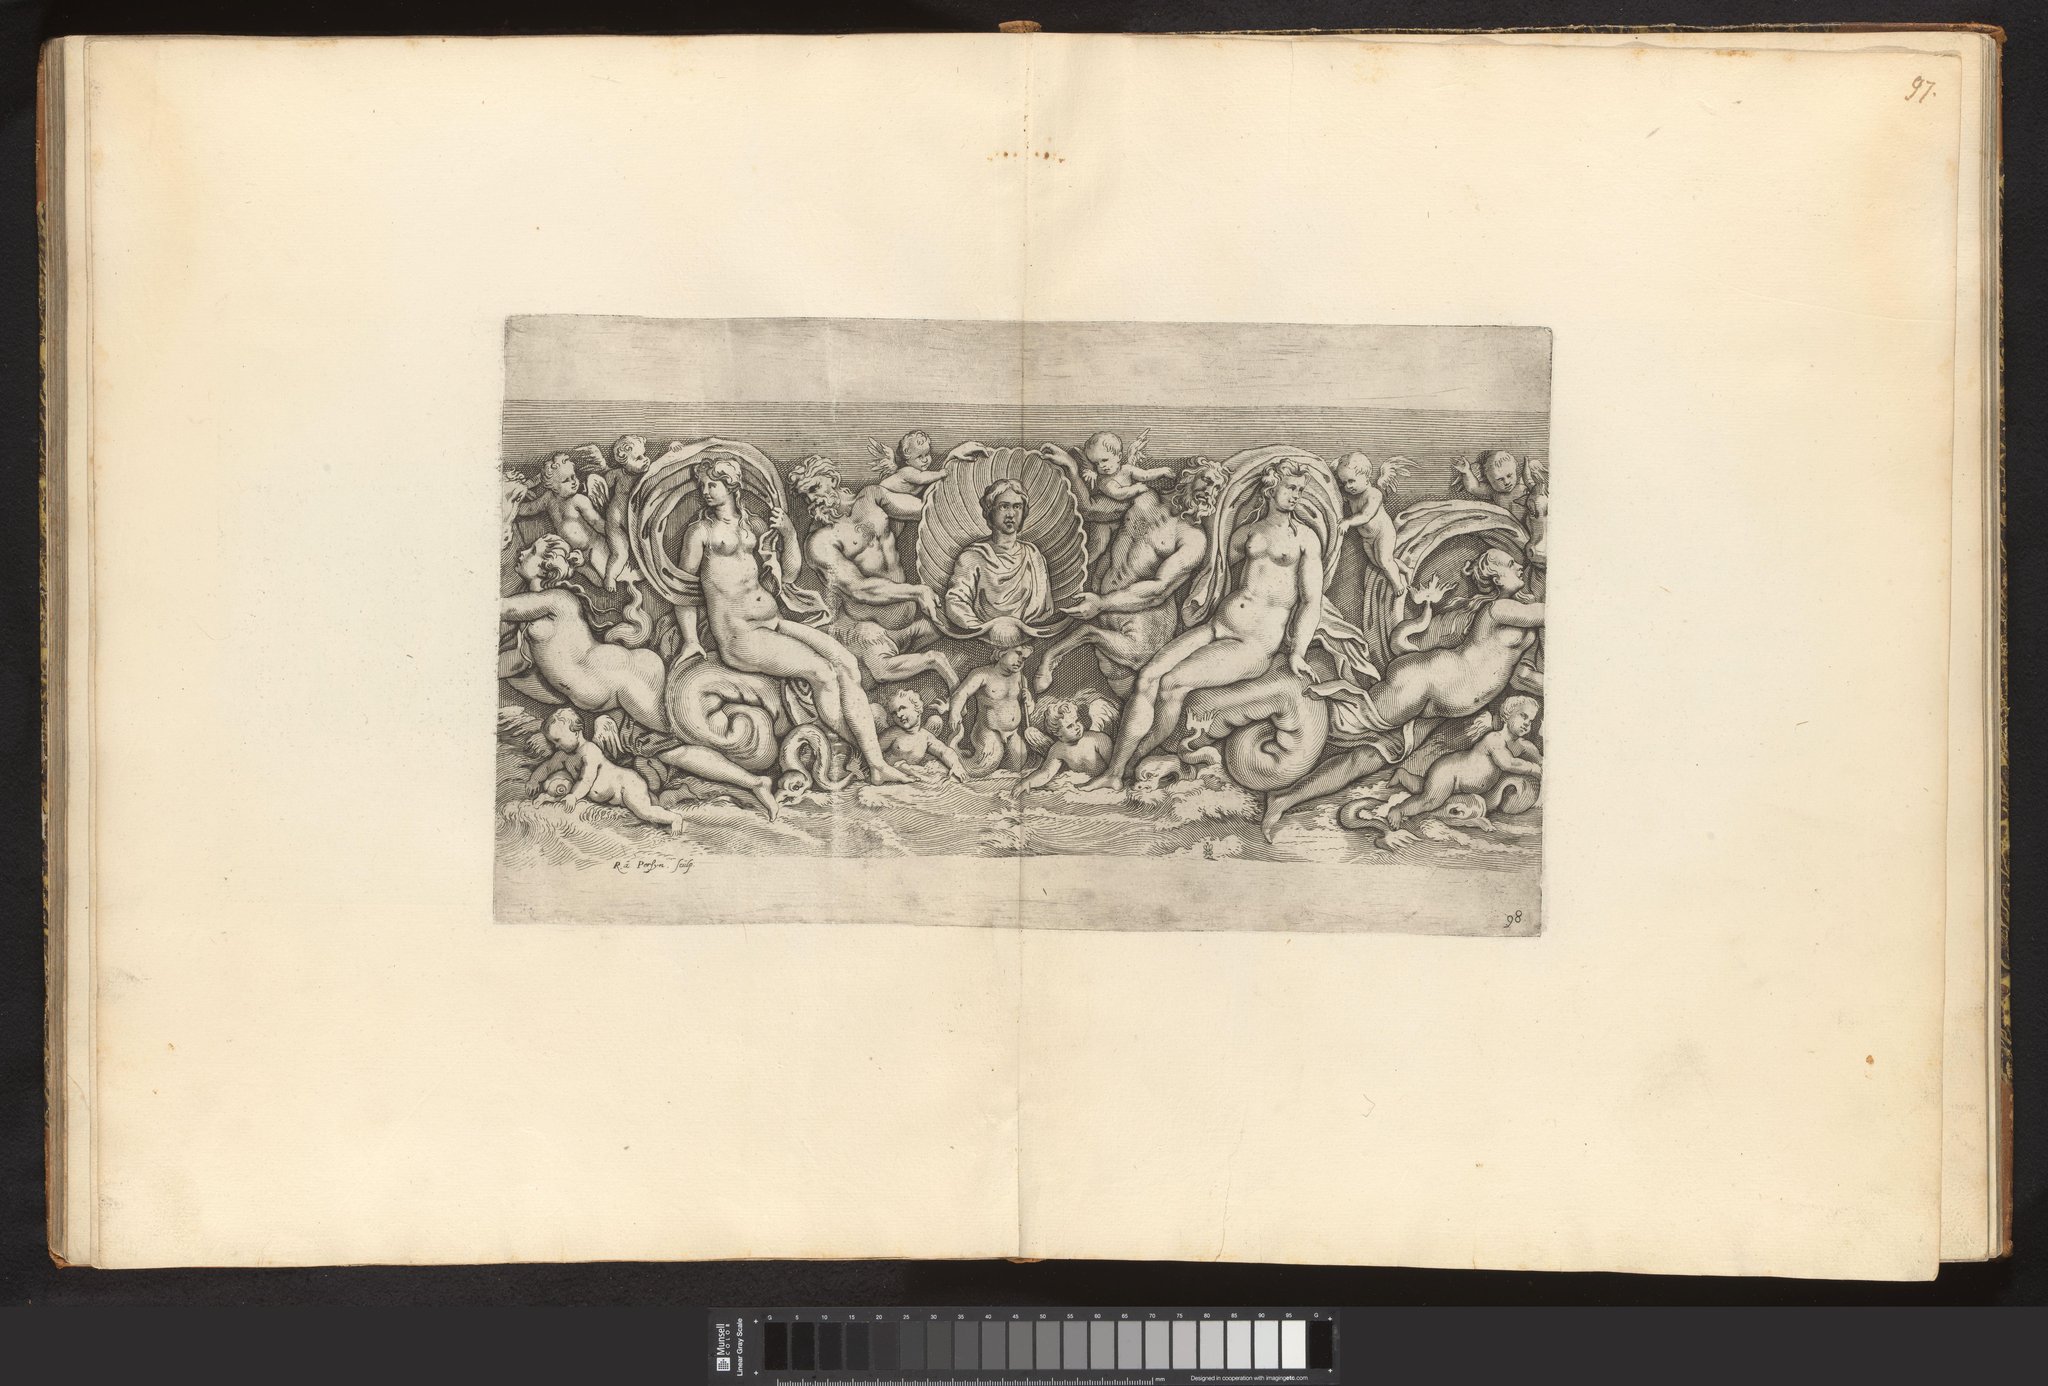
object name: album leaf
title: Bas-reliëf met putti die een medaillion met Romulus en Remus tonen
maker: valérien regnard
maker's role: print maker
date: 1636-1647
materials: paper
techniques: engraving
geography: rome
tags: romulus and remus are washed ashore and suckled by a she-wolf; 'lupa romana', piece of sculpture, reproduction of a piece of sculpture, cupids: 'amores', 'amoretti', 'putti'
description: Bas-reliëf met putti die een medaillion tonen. Op het medaillon Romulus en Remus die gezoogd worden door de wolf. Midden onder het wapenschild van Vincenzo Giustiniani. Prent maakt deel uit van een album met een serie prenten naar de sculpturen in de verzameling in de Galleria Giustiniani te Rome.